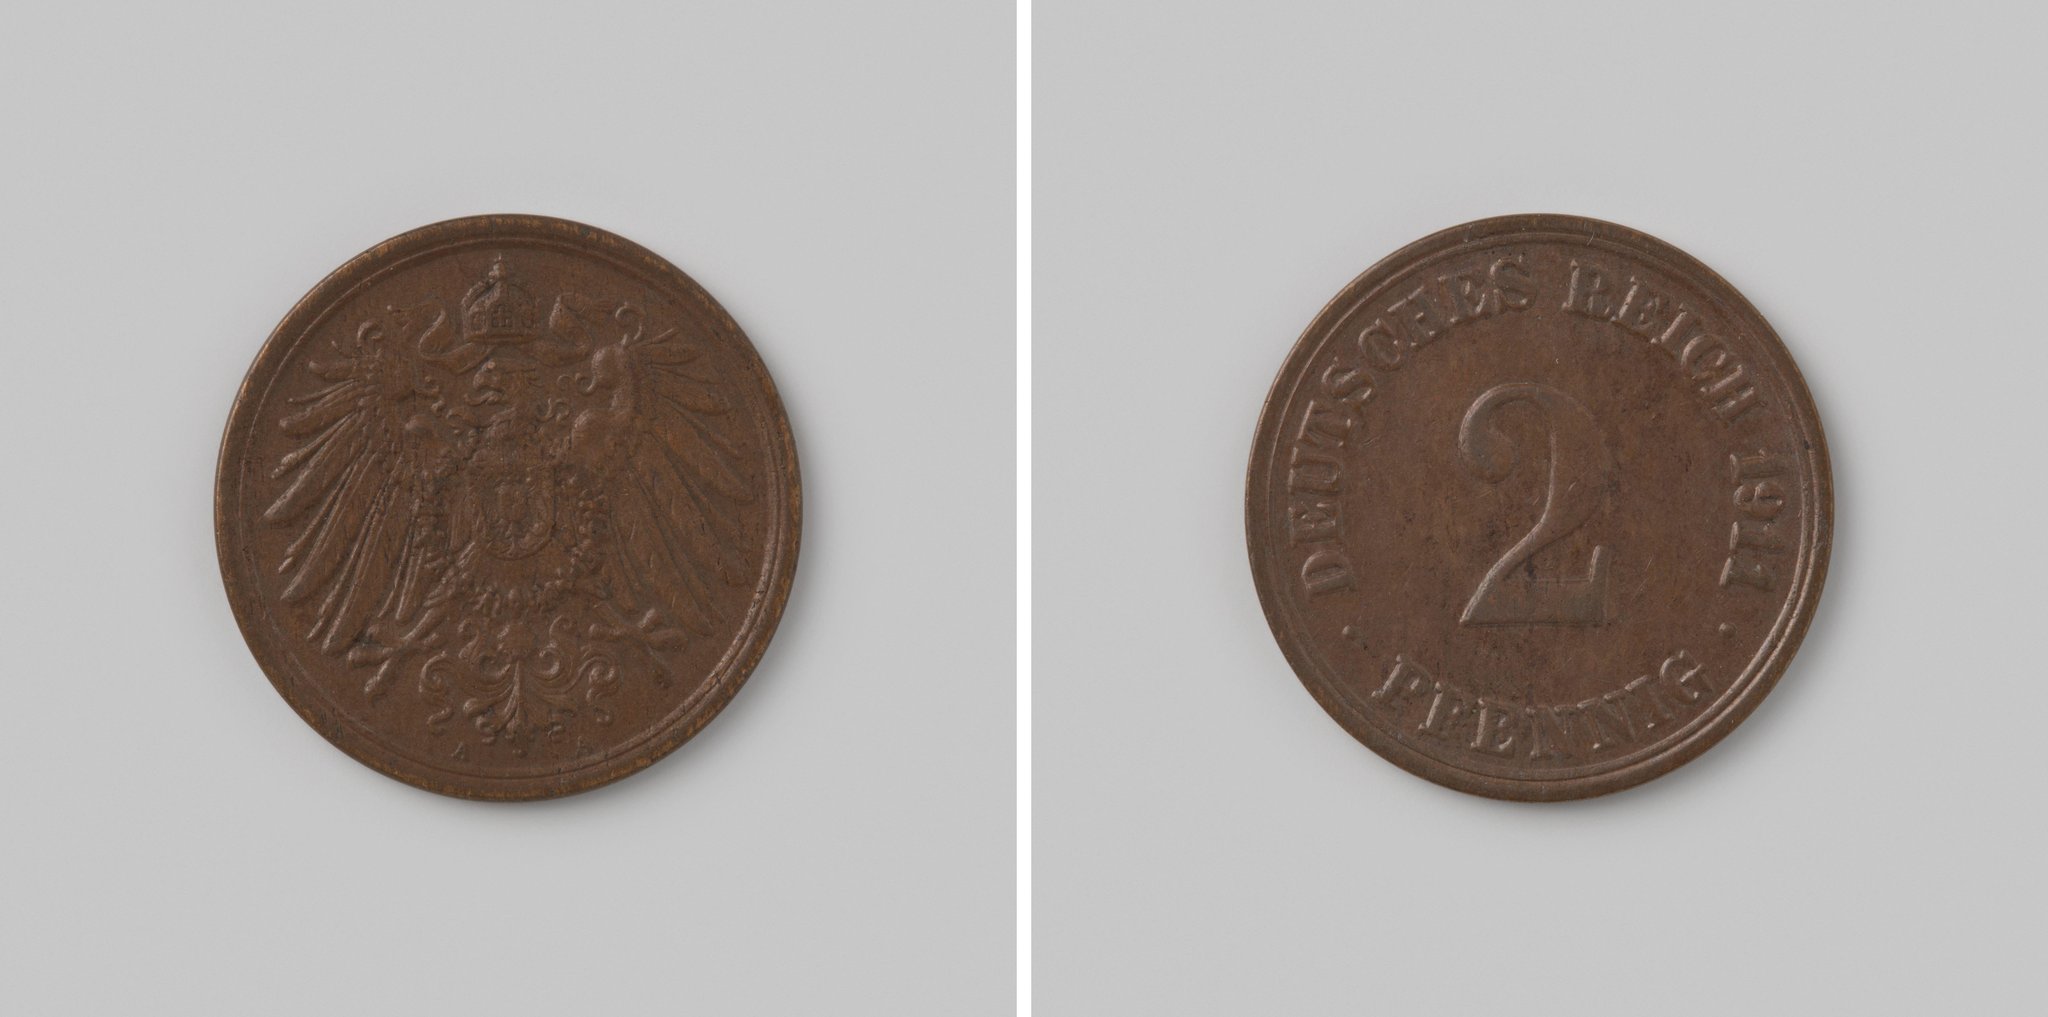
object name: twee pfennig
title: Duitse Rijk, 2 Pfennig, 1911 A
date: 1911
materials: copper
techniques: striking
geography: berlin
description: Koperen munt. Voorzijde: gekroonde enkelkoppige adelaar naar links met op borst door keten van orde met juweel omhangen samengesteld wapenschild. Daaronder twee letters A. Keerzijde: waarde-aanduiding in twee regels. Jaartal in omschrift. Gladde rand.